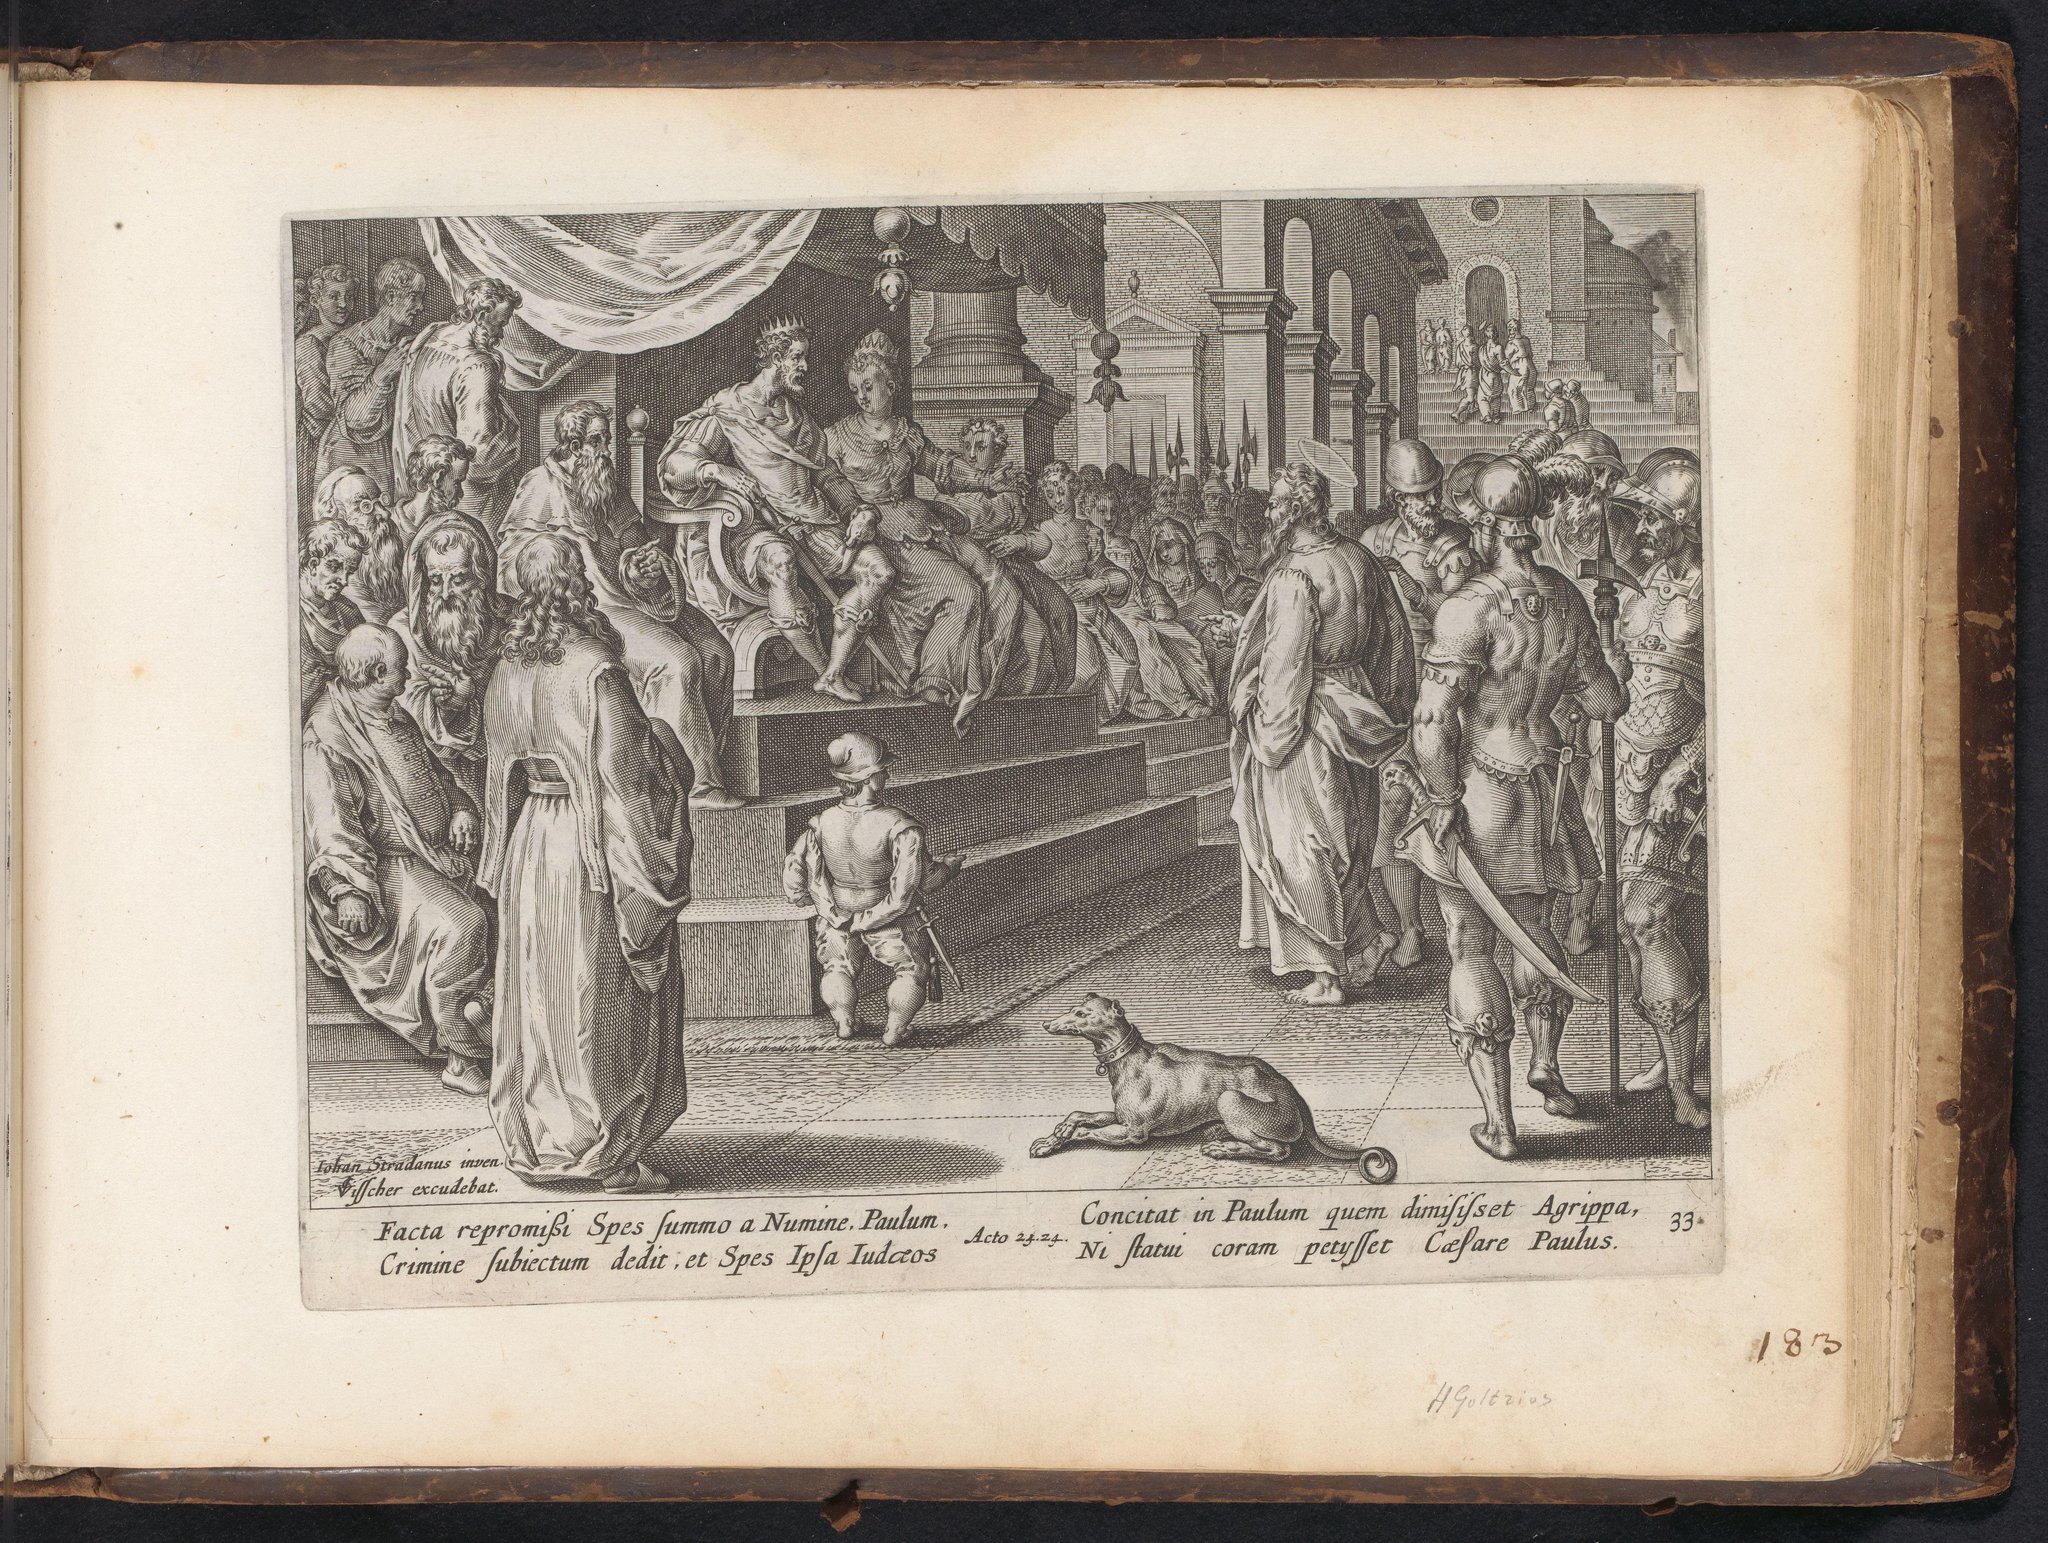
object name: print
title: Pauli lyden te Ierusalem en Elders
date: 1643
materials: paper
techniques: engraving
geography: amsterdam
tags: paul before felix and drusilla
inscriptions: number: ‘183’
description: Paulus wordt door Festus aan koning Agrippa en Bernice voorgeleid. Er wordt besloten Paulus naar Rome te sturen. Onder de voorstelling een verwijzing in het Latijn naar de Bijbeltekst in Hand. 25:25. Het genoemde vers is echter Hand. 24:24. Het kan zijn dat deze prent verwijst naar een ander thema: Paulus voorgeleid aan Felix en zijn vrouw Drusilla. Deze prent maakt deel uit van een album.